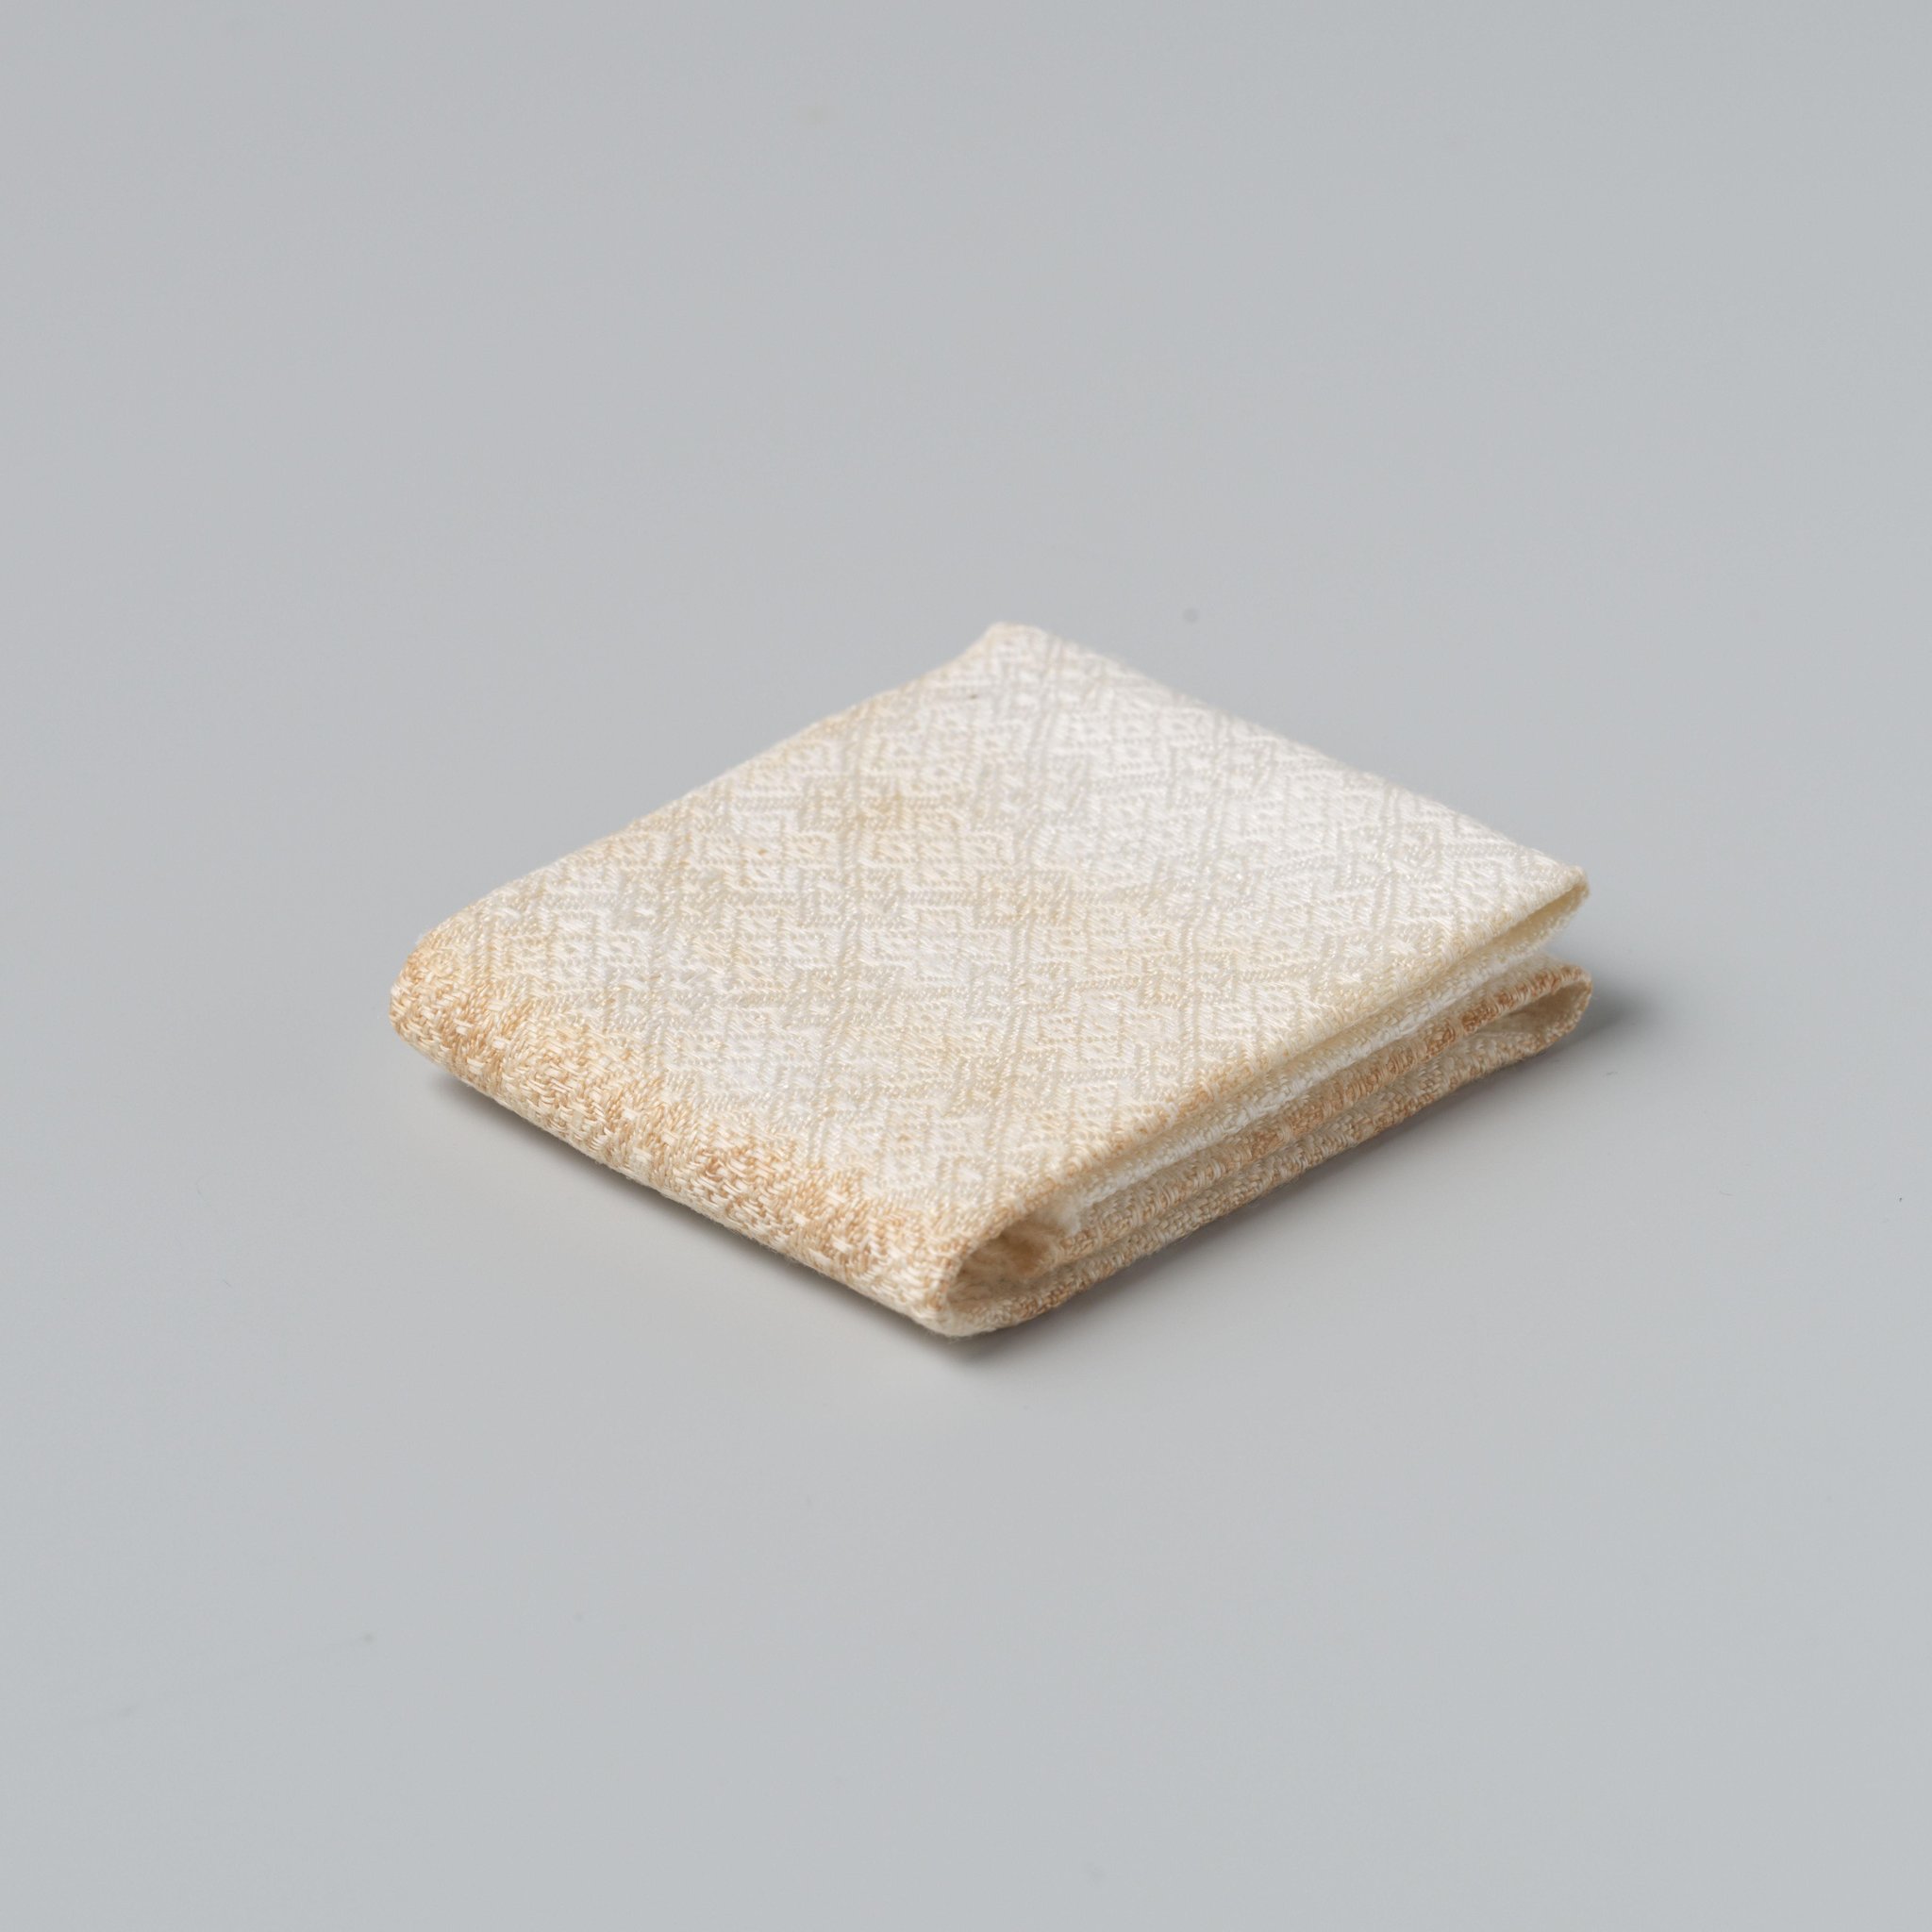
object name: miniature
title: Tafellaken, servet of handdoek van linnen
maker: Anonymous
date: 1600-1699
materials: linen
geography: netherlands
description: Tafellaken, servet of handdoek van linnen met een pellenpatroon, geknipt uit een groter stuk linnen. Geen zomen.